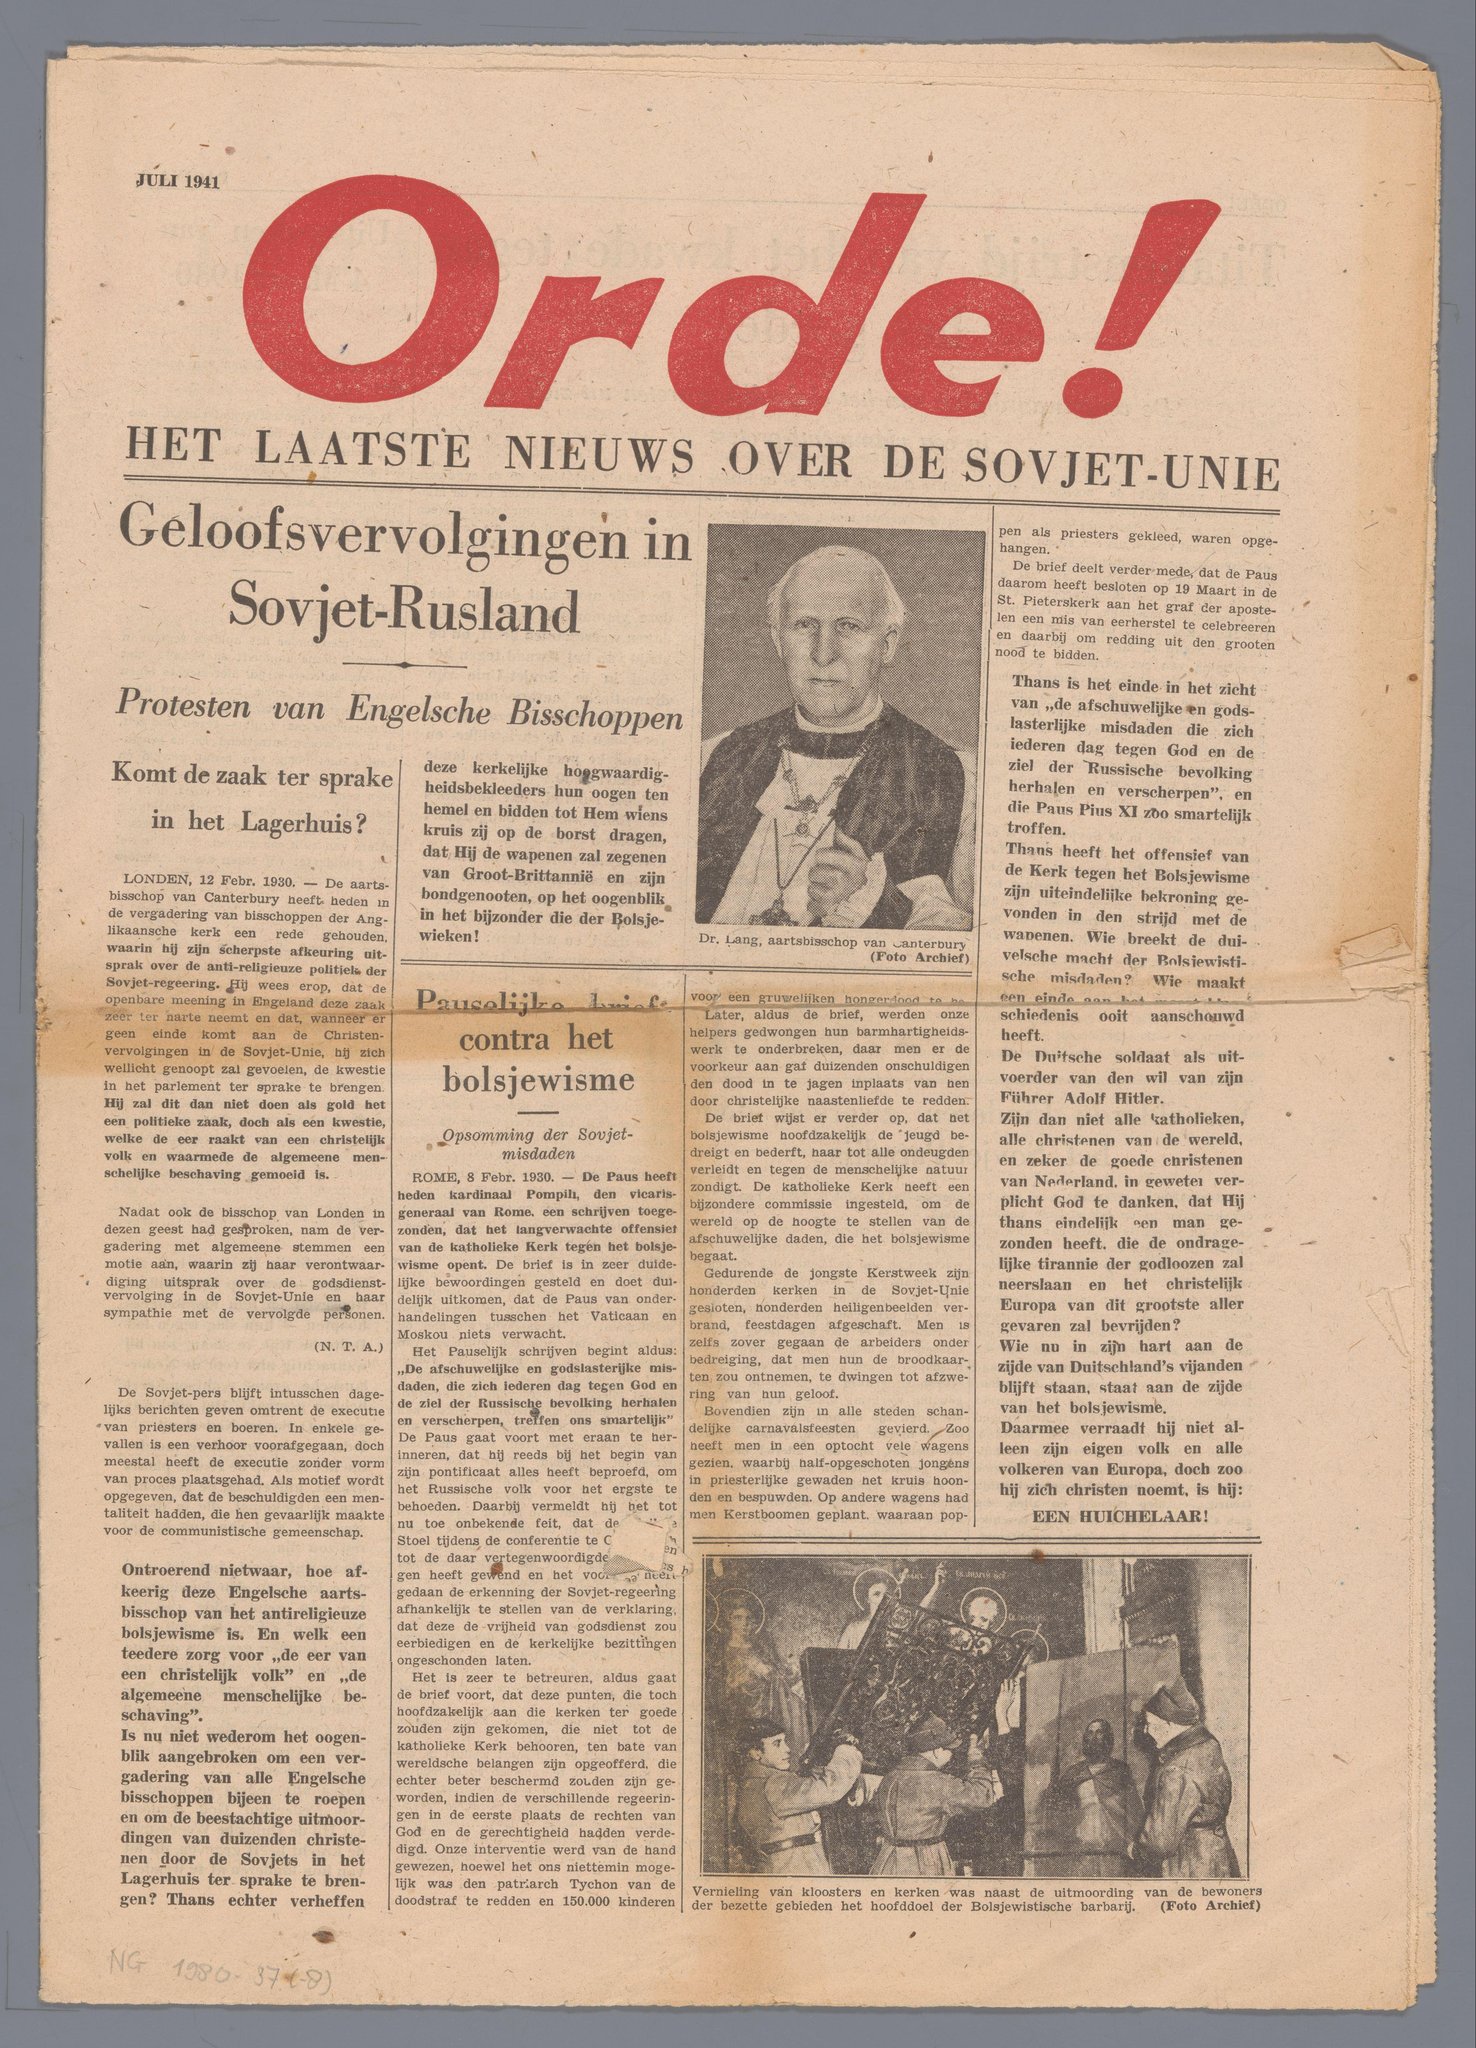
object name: newspaper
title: Orde!; het laatste nieuws over de Sovjet-Unie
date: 1907-1941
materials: paper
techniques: printing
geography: amsterdam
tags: tweede wereldoorlog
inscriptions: date